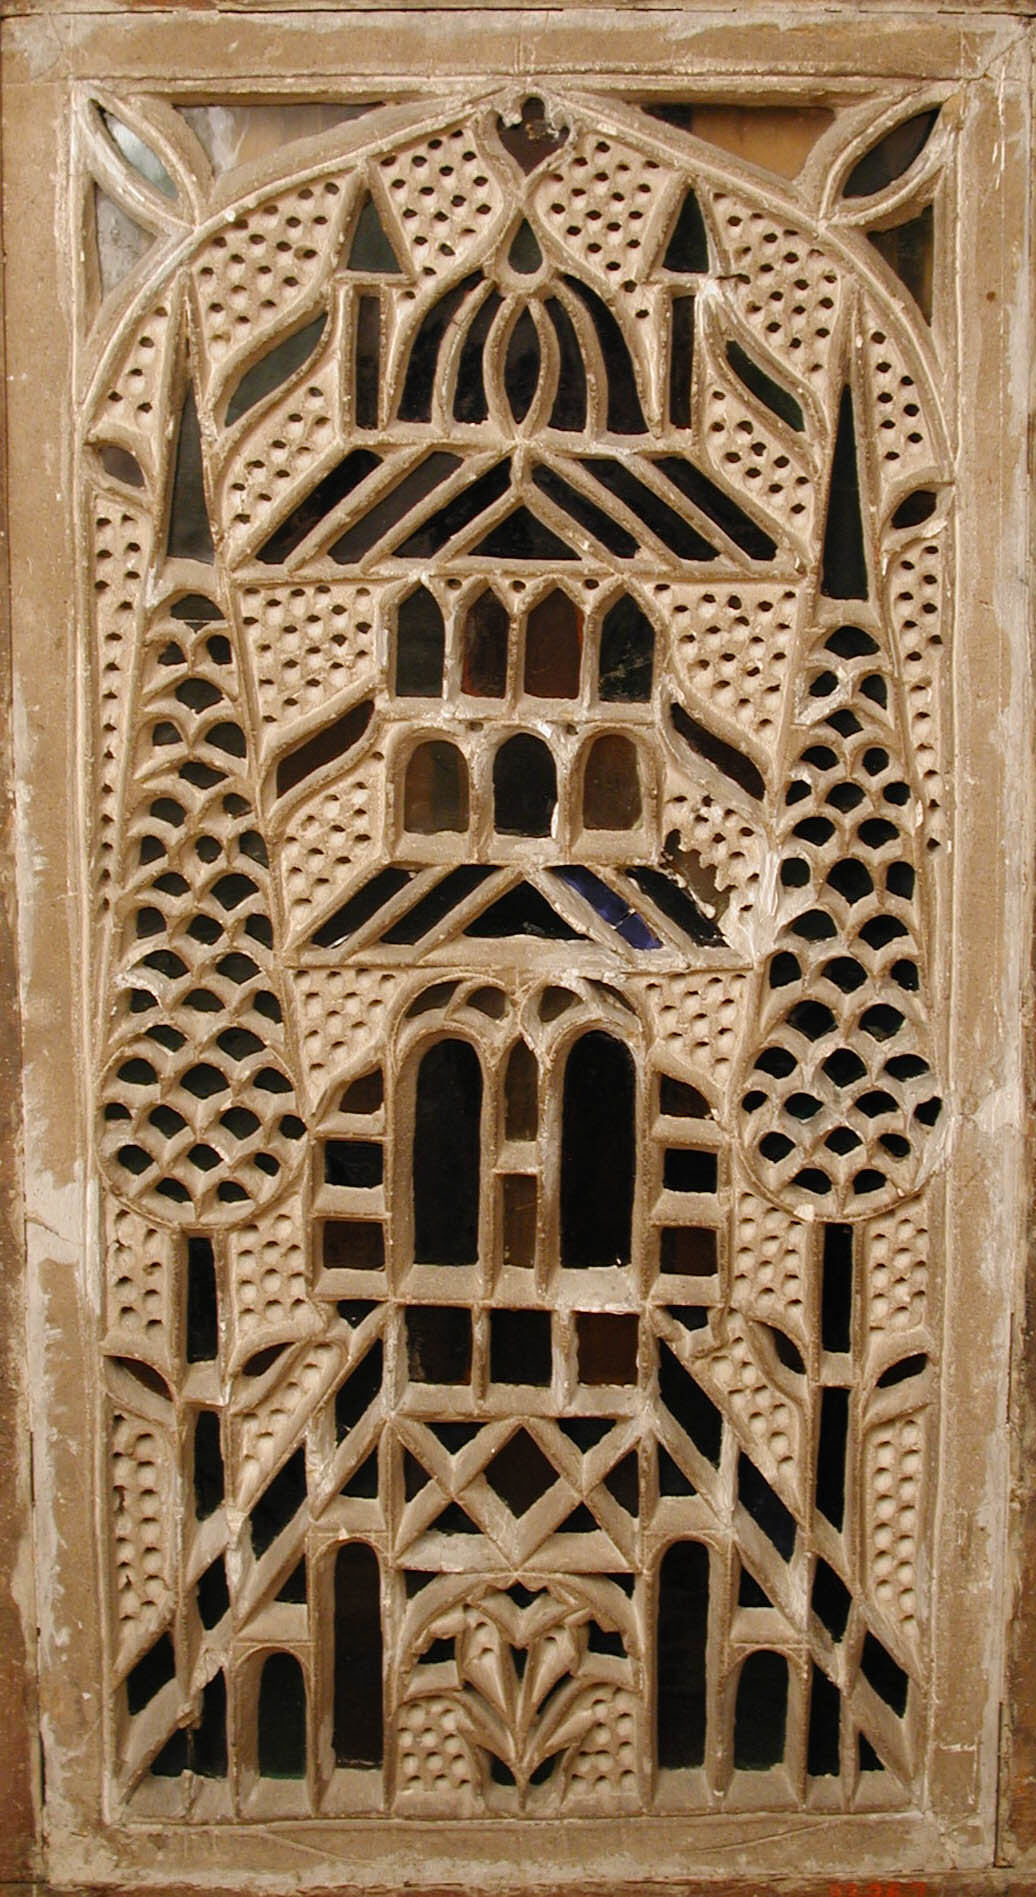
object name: window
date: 1701-1800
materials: gypsum, glass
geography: egypt or syria